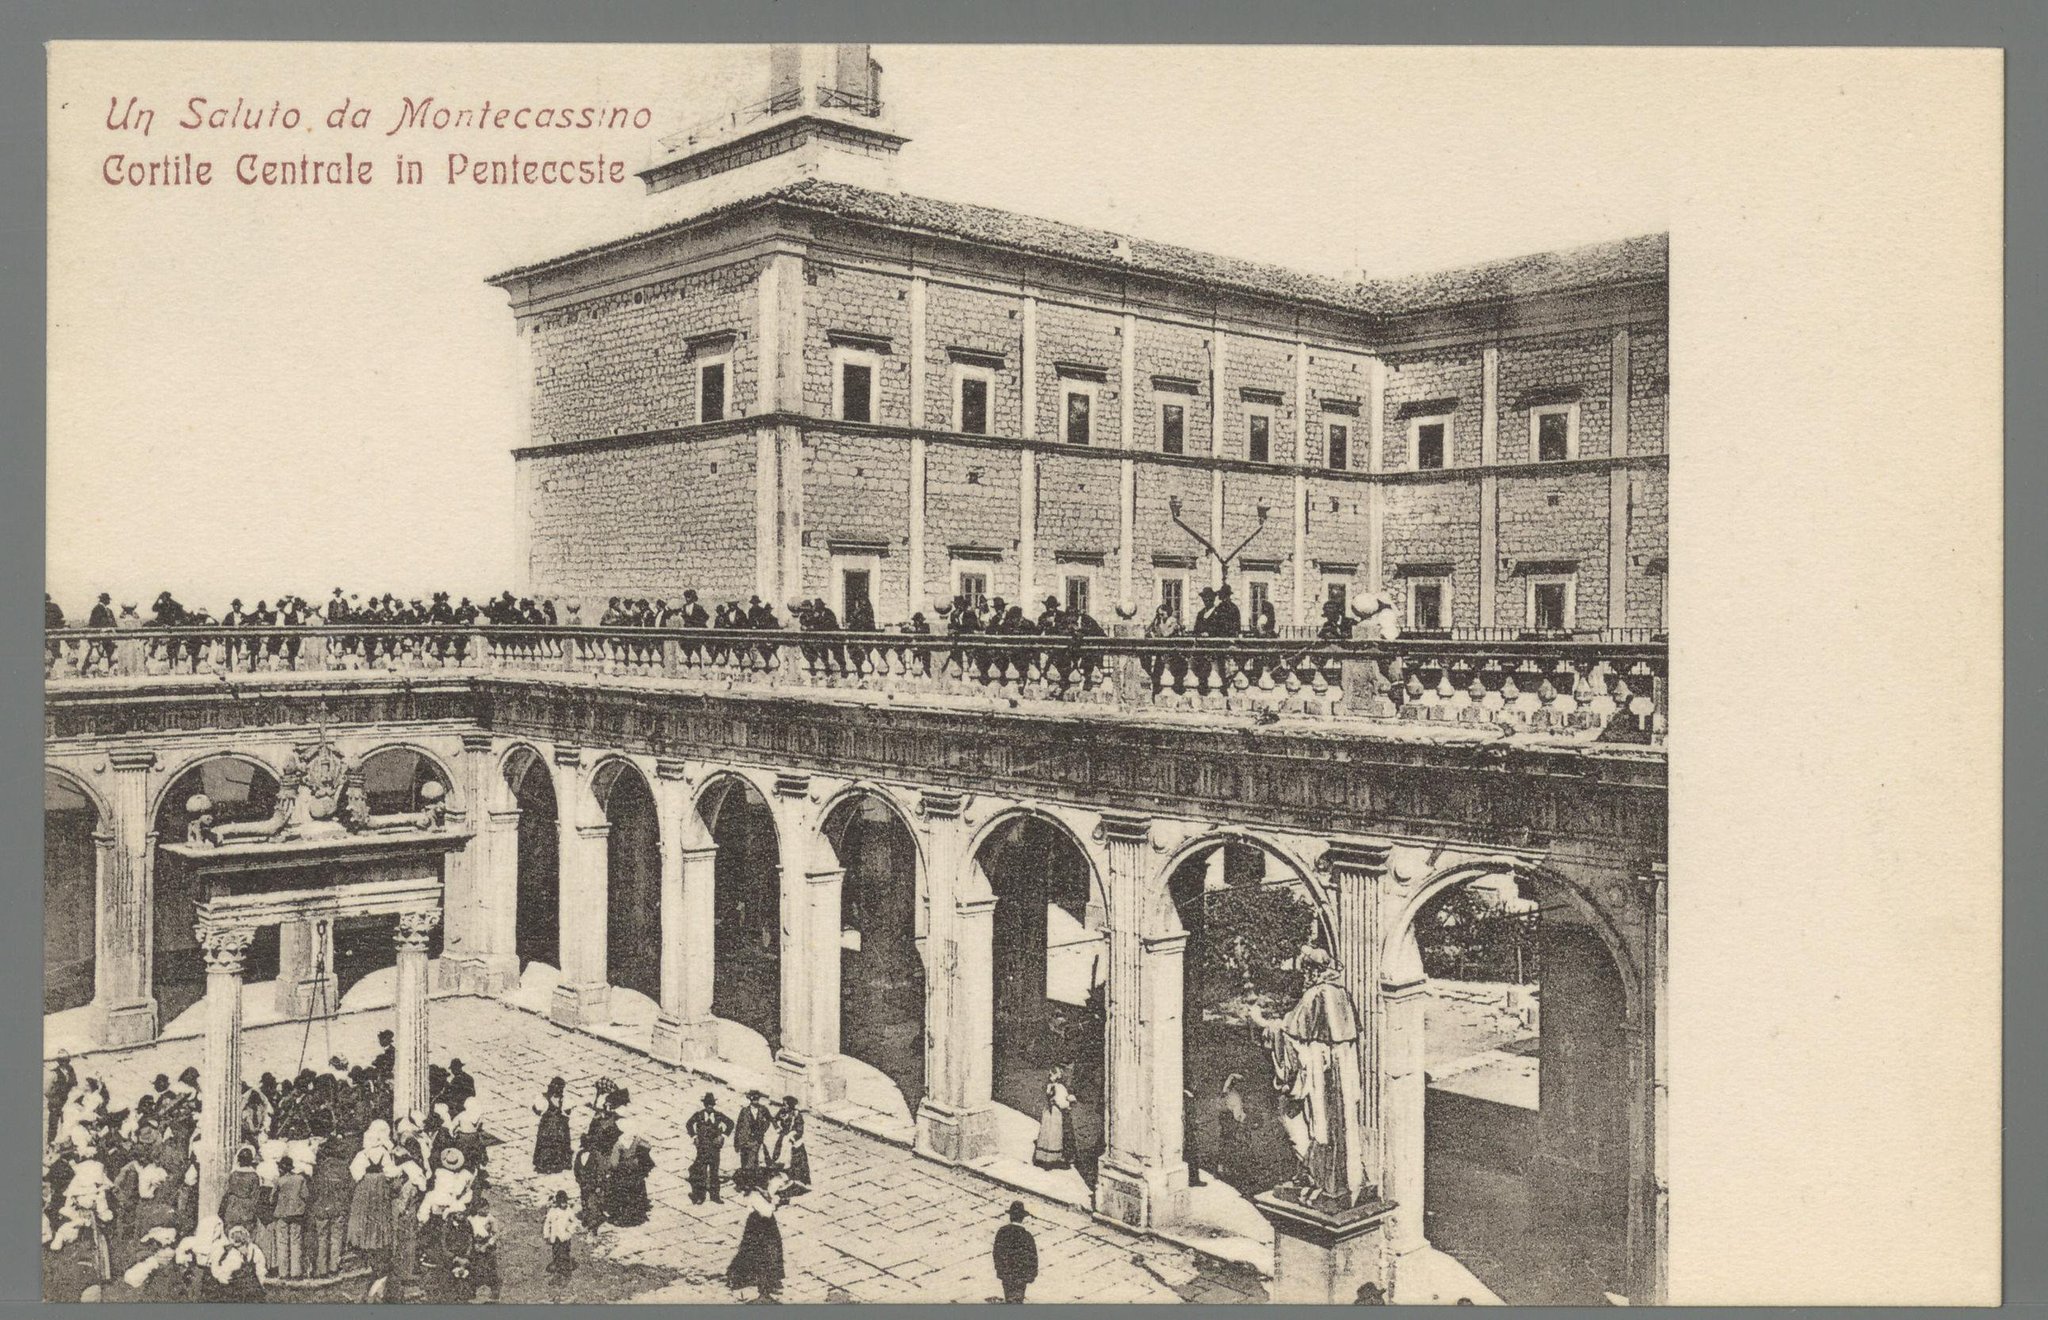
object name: ansichtkaart, prentbriefkaart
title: Cortile Centrale in Pentecoste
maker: Anonymous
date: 1889-1910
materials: cardboard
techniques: photograph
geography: terni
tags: abbey, monastery, convent ~ roman catholic church, inner court of palace or 'hôtel'